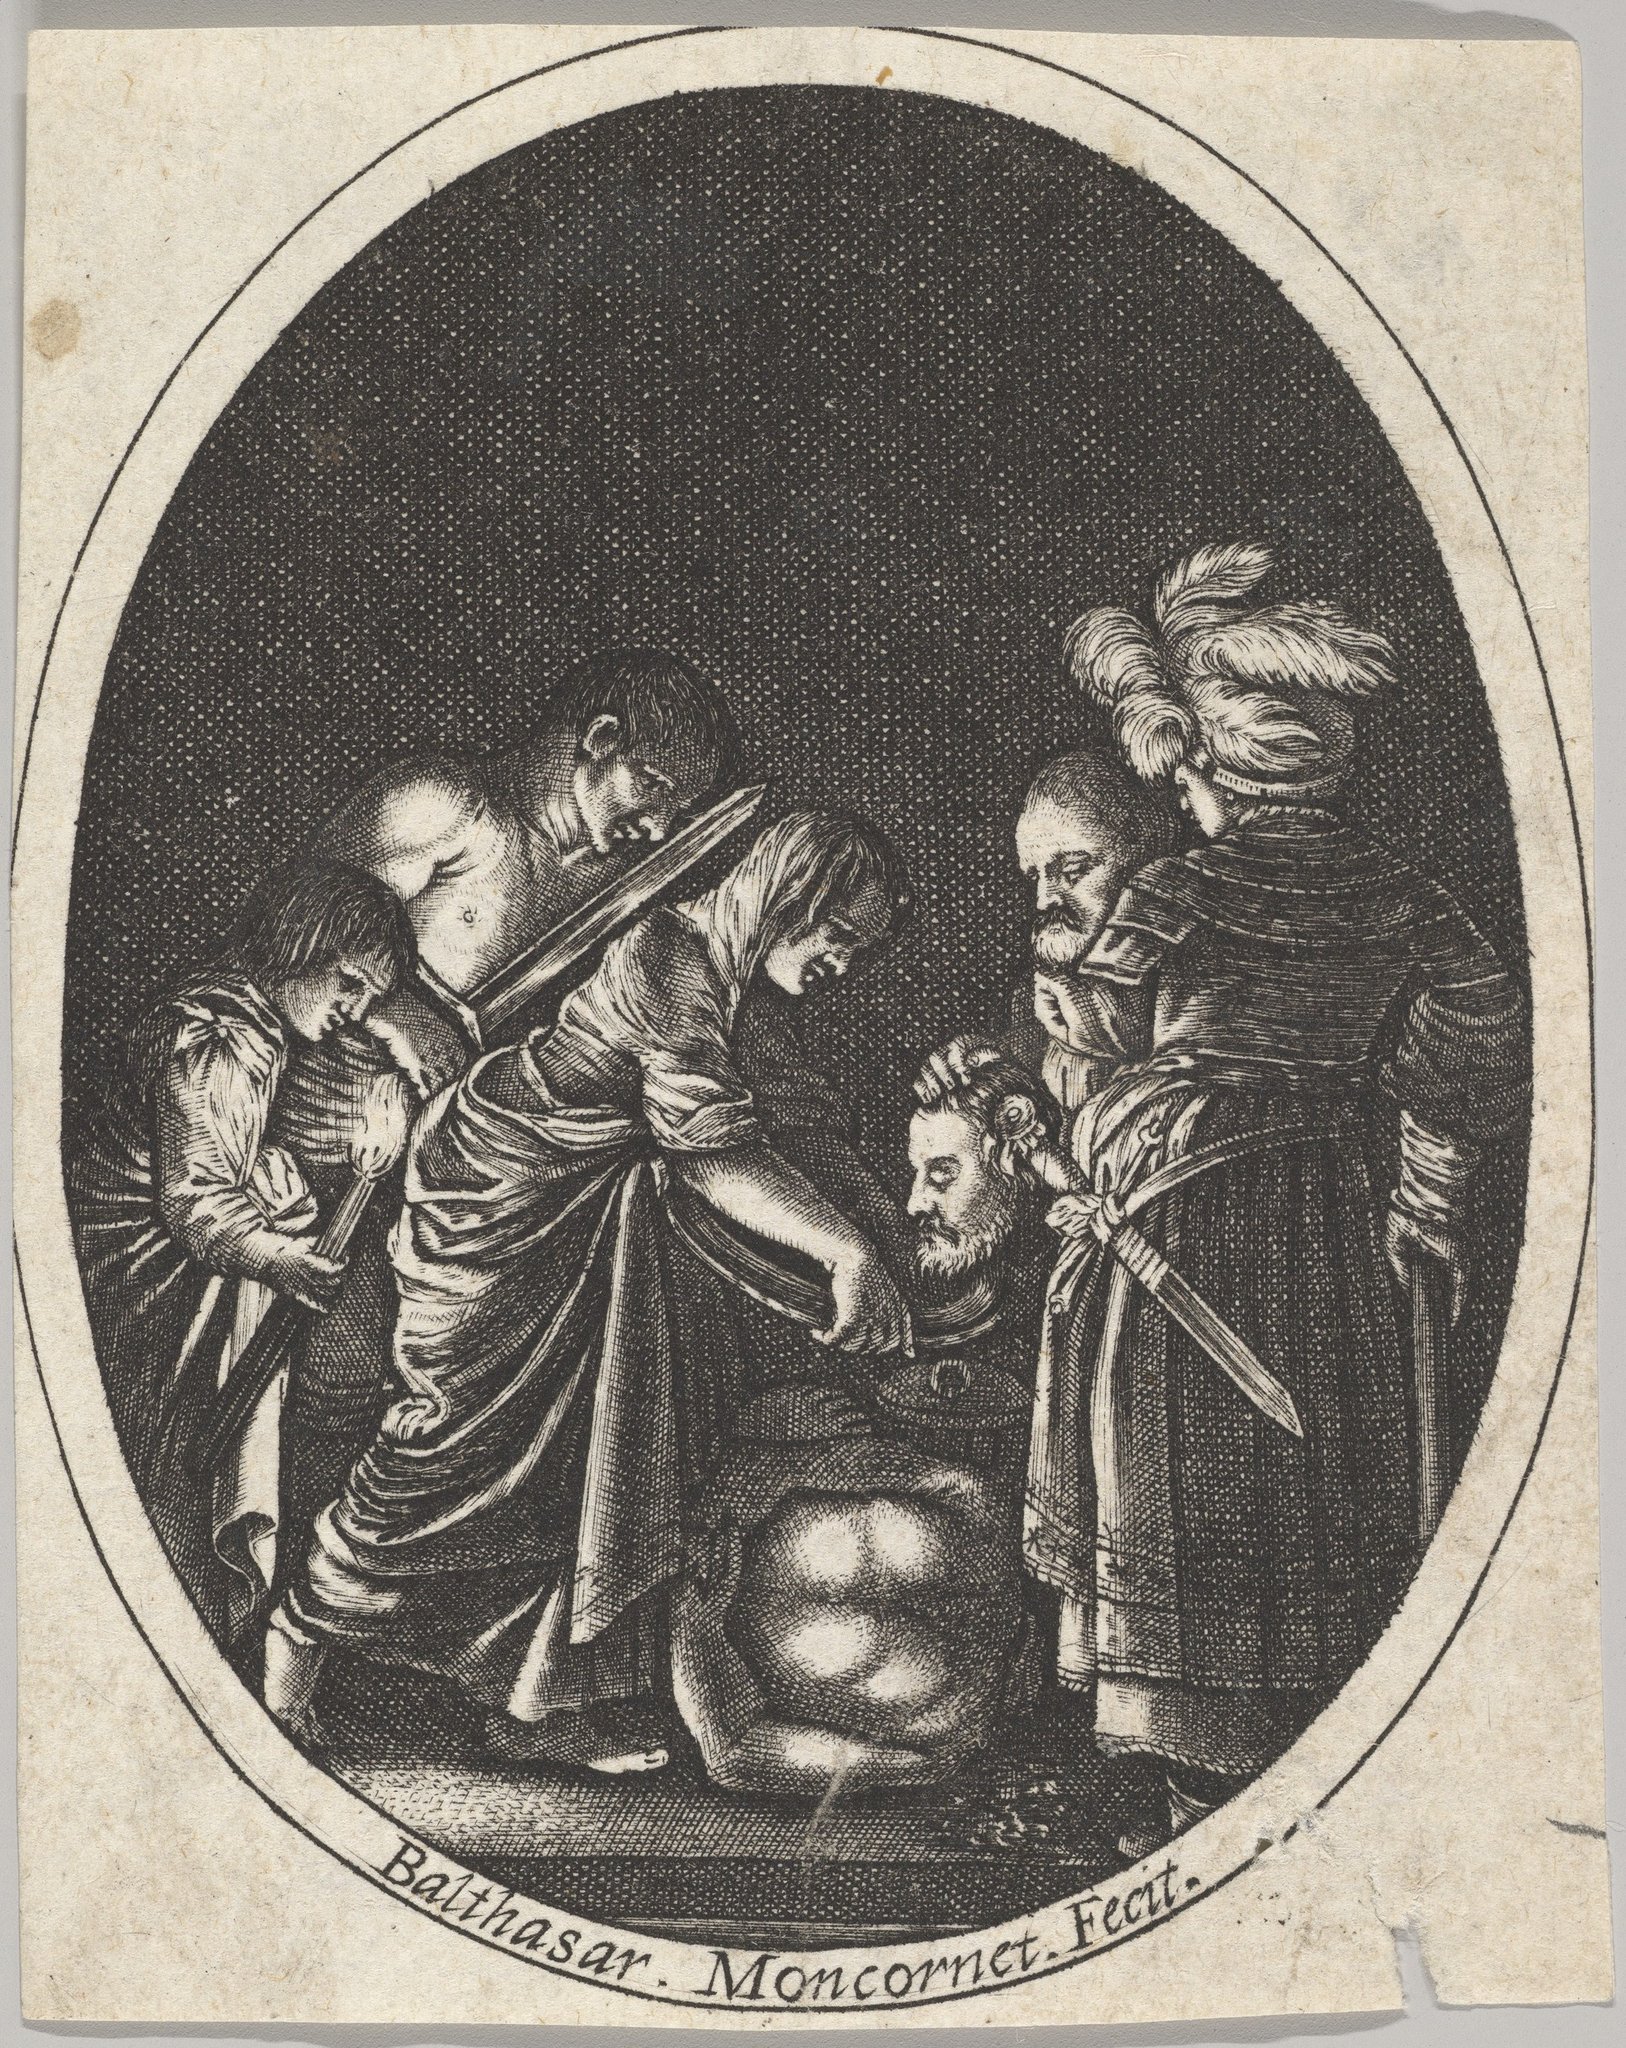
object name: print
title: Salome receiving the head of John the Baptist, surrounded by three men and a child bearing a torch, the Baptist's body lies on the ground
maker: balthazar moncornet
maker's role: artist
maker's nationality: french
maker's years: 1600-1668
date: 1630-1668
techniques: engraving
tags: swords,children,men,saint john the baptist